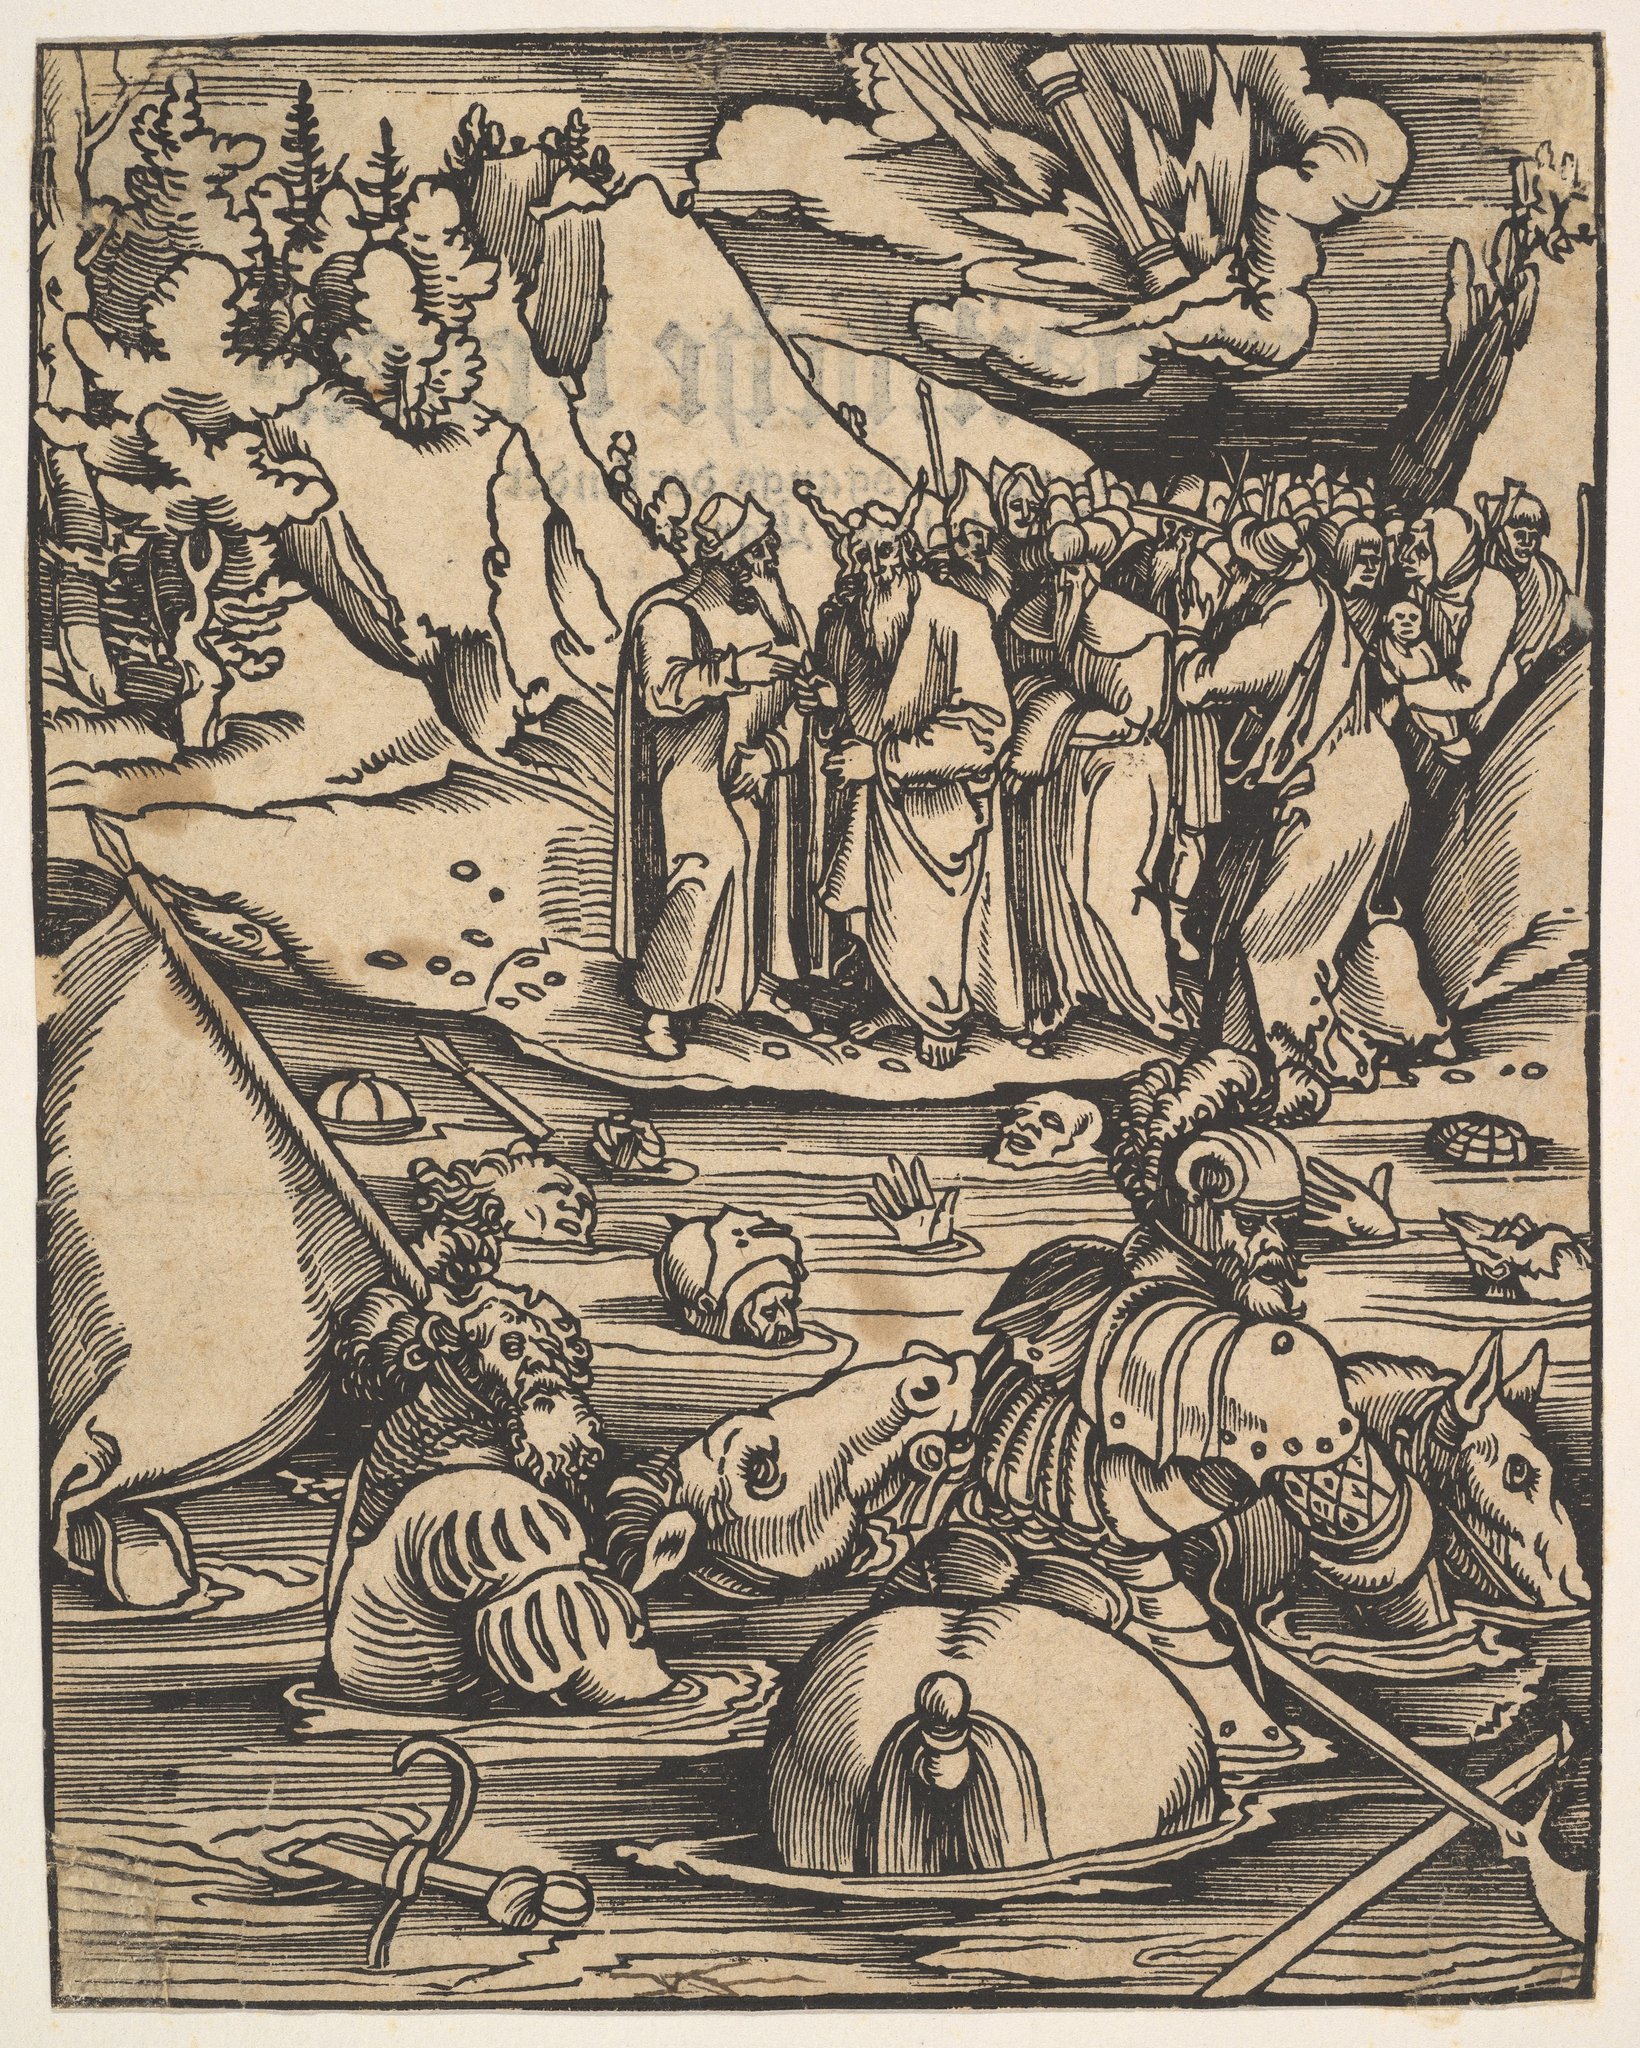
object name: print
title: The Egyptians Crossing the Red Sea, from Das Buch Granatapfel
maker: hans baldung (called hans baldung grien)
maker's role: artist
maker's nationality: german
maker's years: 1484-1545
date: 1511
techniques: letterpress, woodcut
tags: men,horses